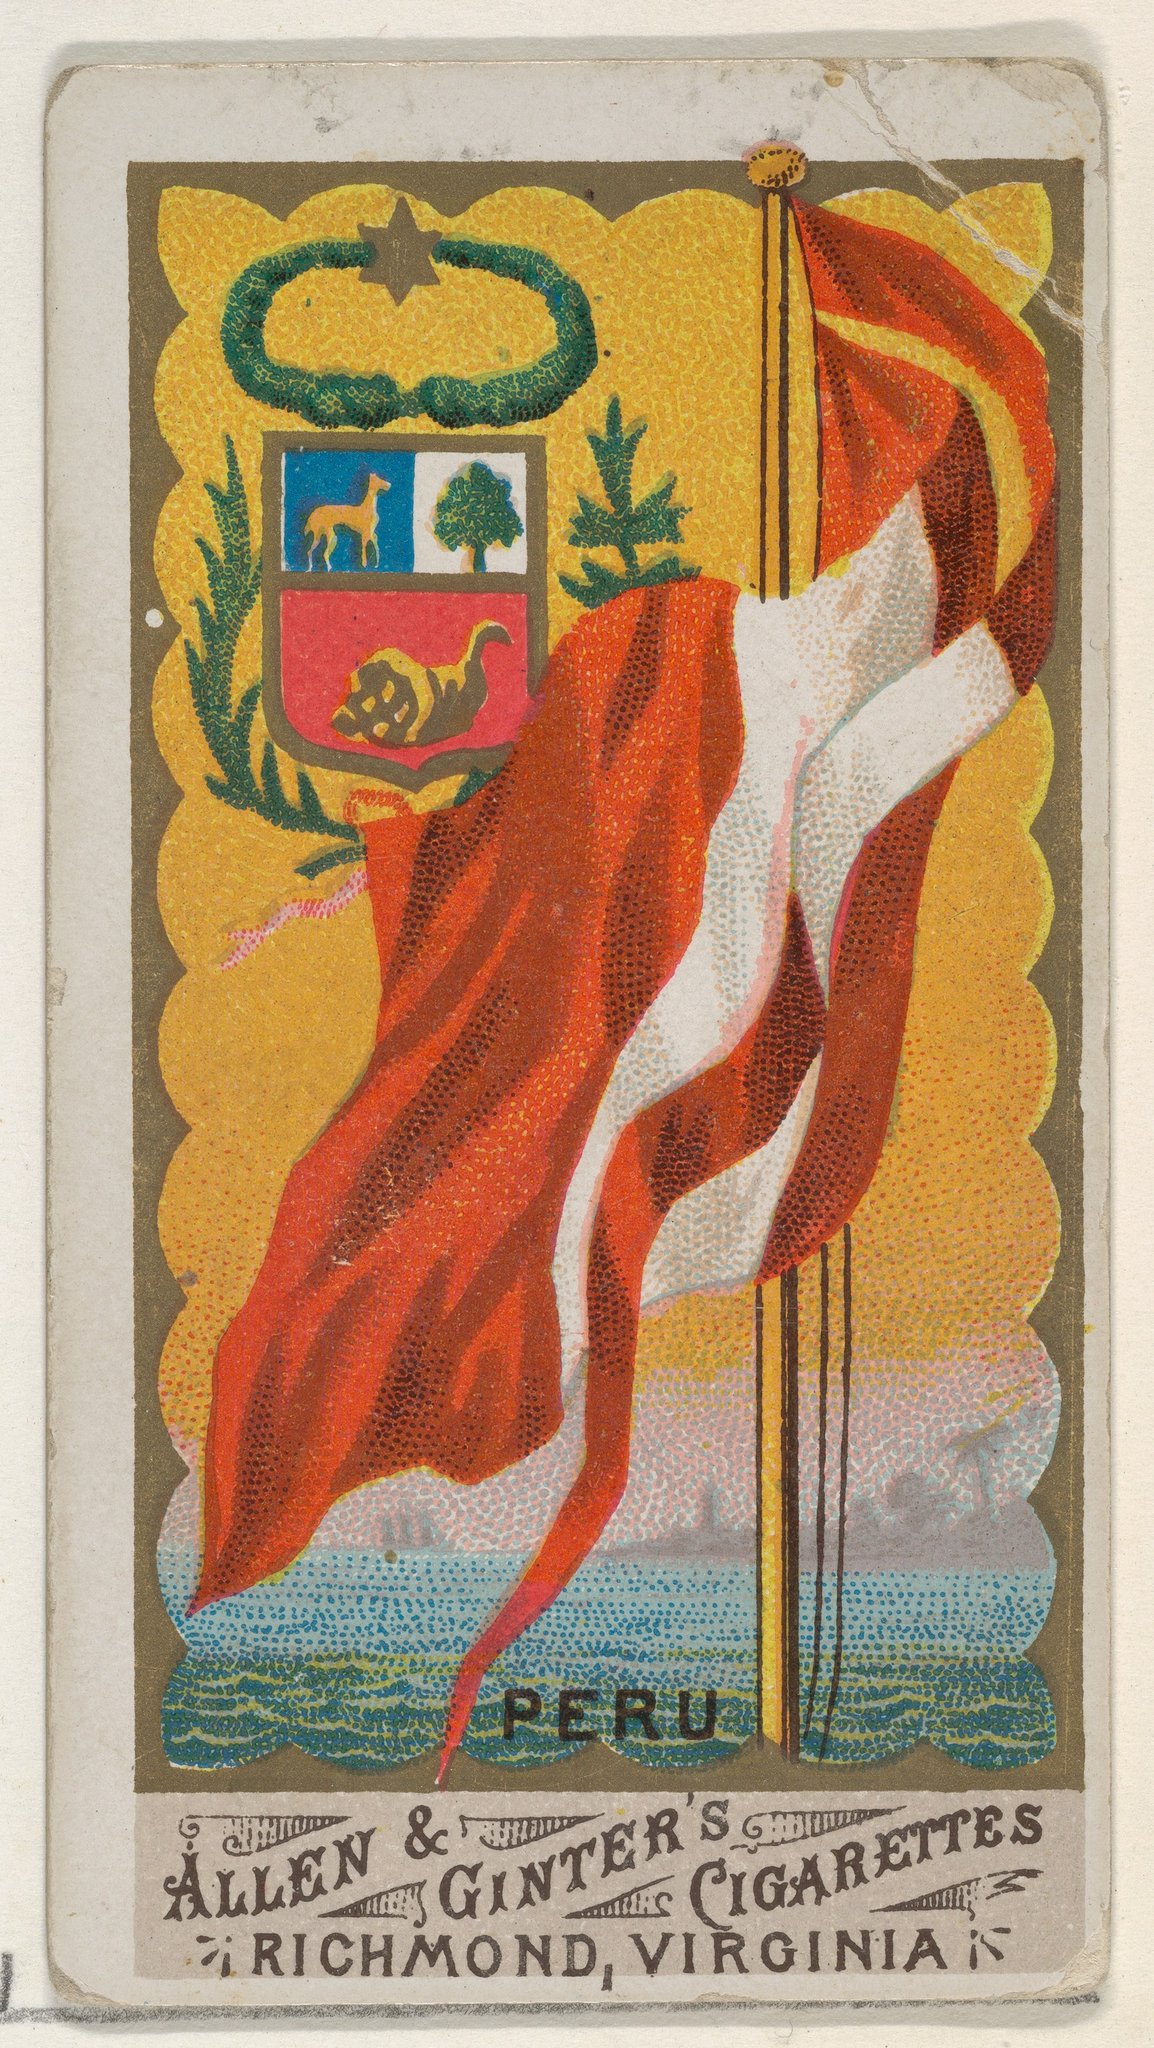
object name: print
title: Peru, from Flags of All Nations, Series 1 (N9) for Allen & Ginter Cigarettes Brands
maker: allen & ginter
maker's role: publisher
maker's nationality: american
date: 1887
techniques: color lithograph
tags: coat of arms,flags